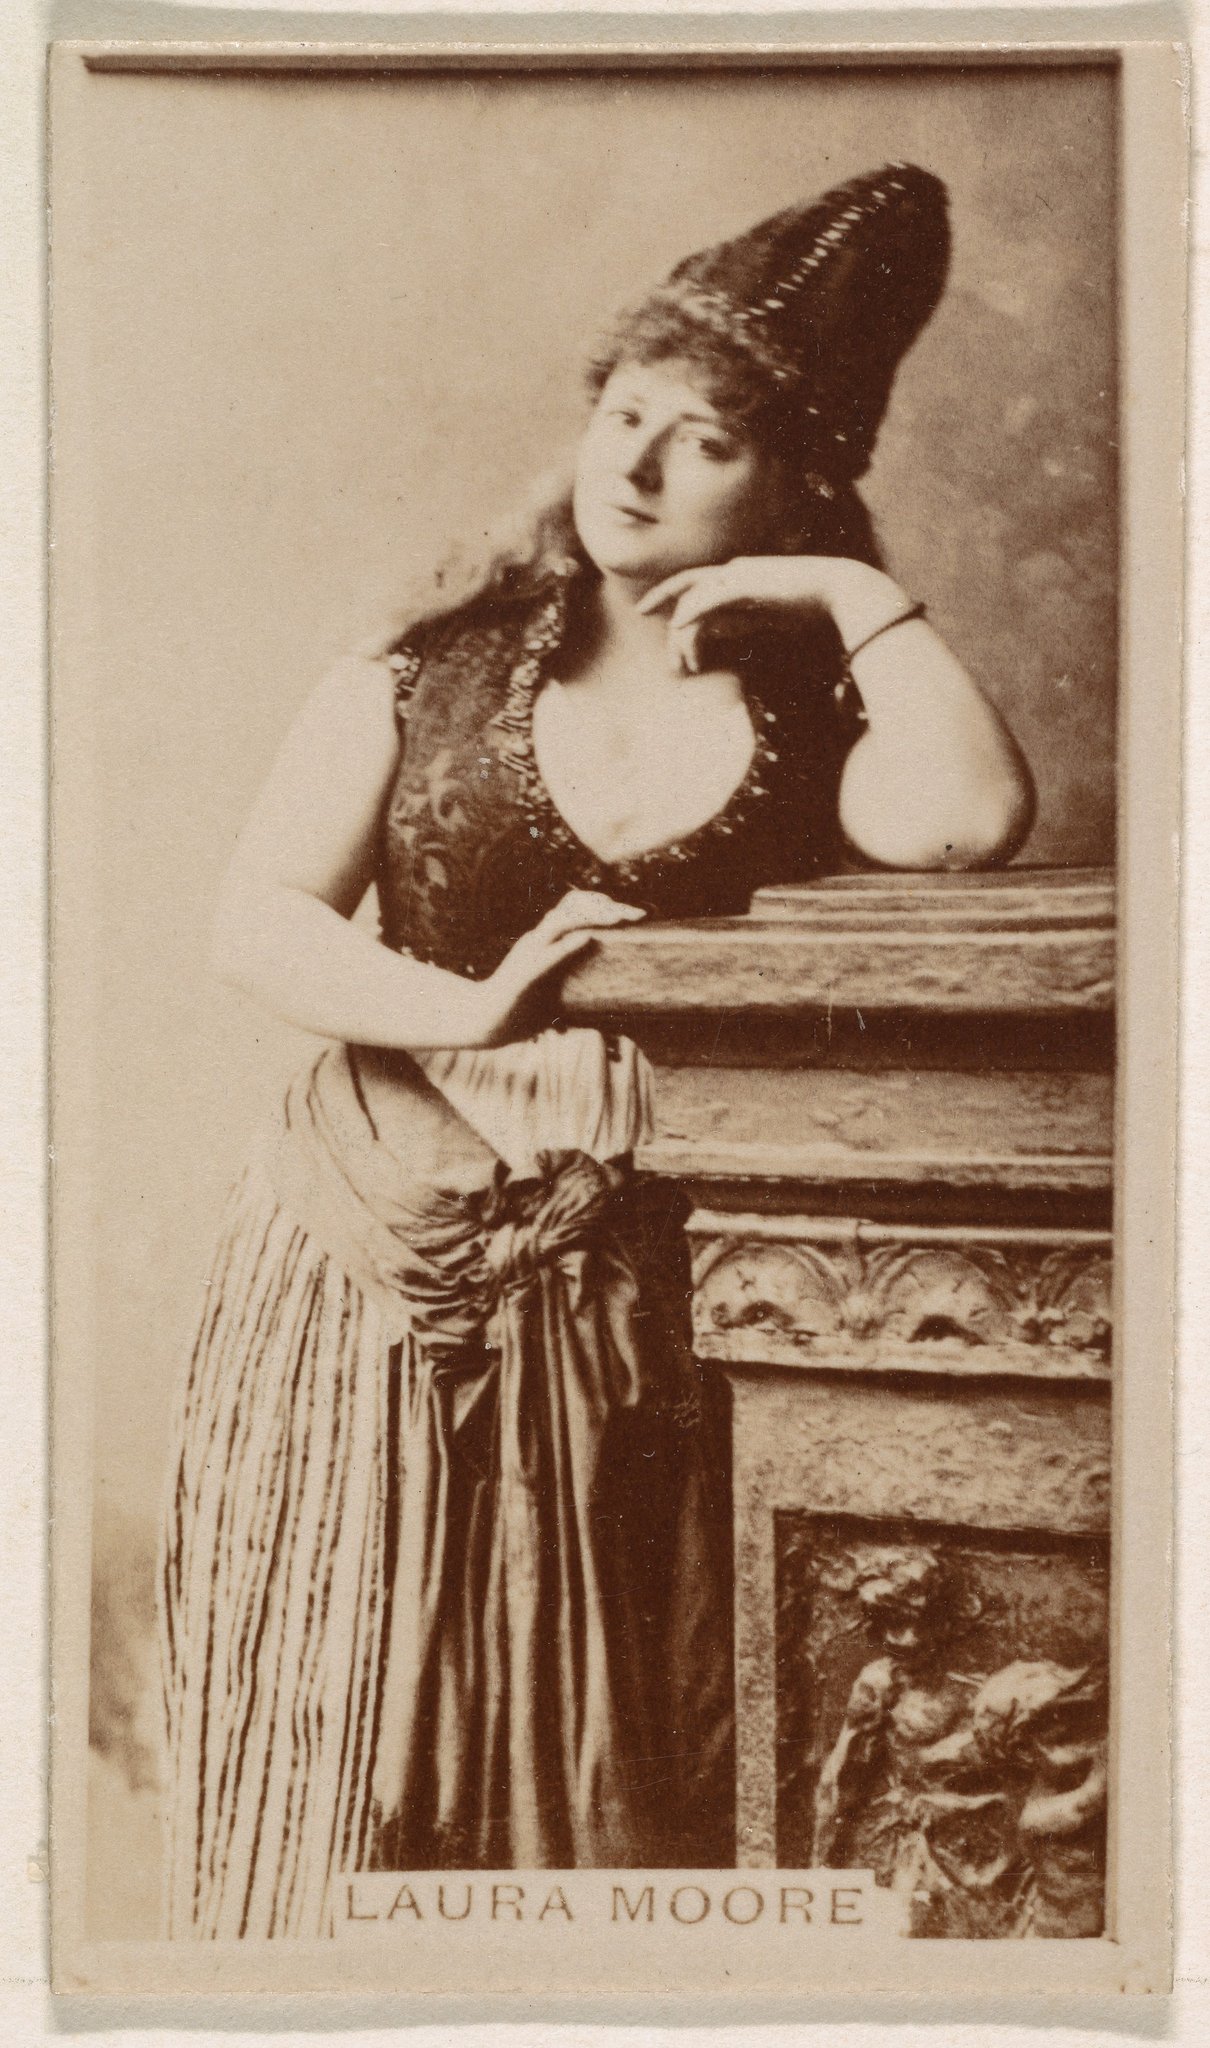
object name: photograph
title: Laura Moore, from the Actresses series (N245) issued by Kinney Brothers to promote Sweet Caporal Cigarettes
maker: kinney brothers tobacco company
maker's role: publisher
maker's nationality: american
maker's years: 1869-2011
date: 1890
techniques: albumen silver print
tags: portraits,women,actresses